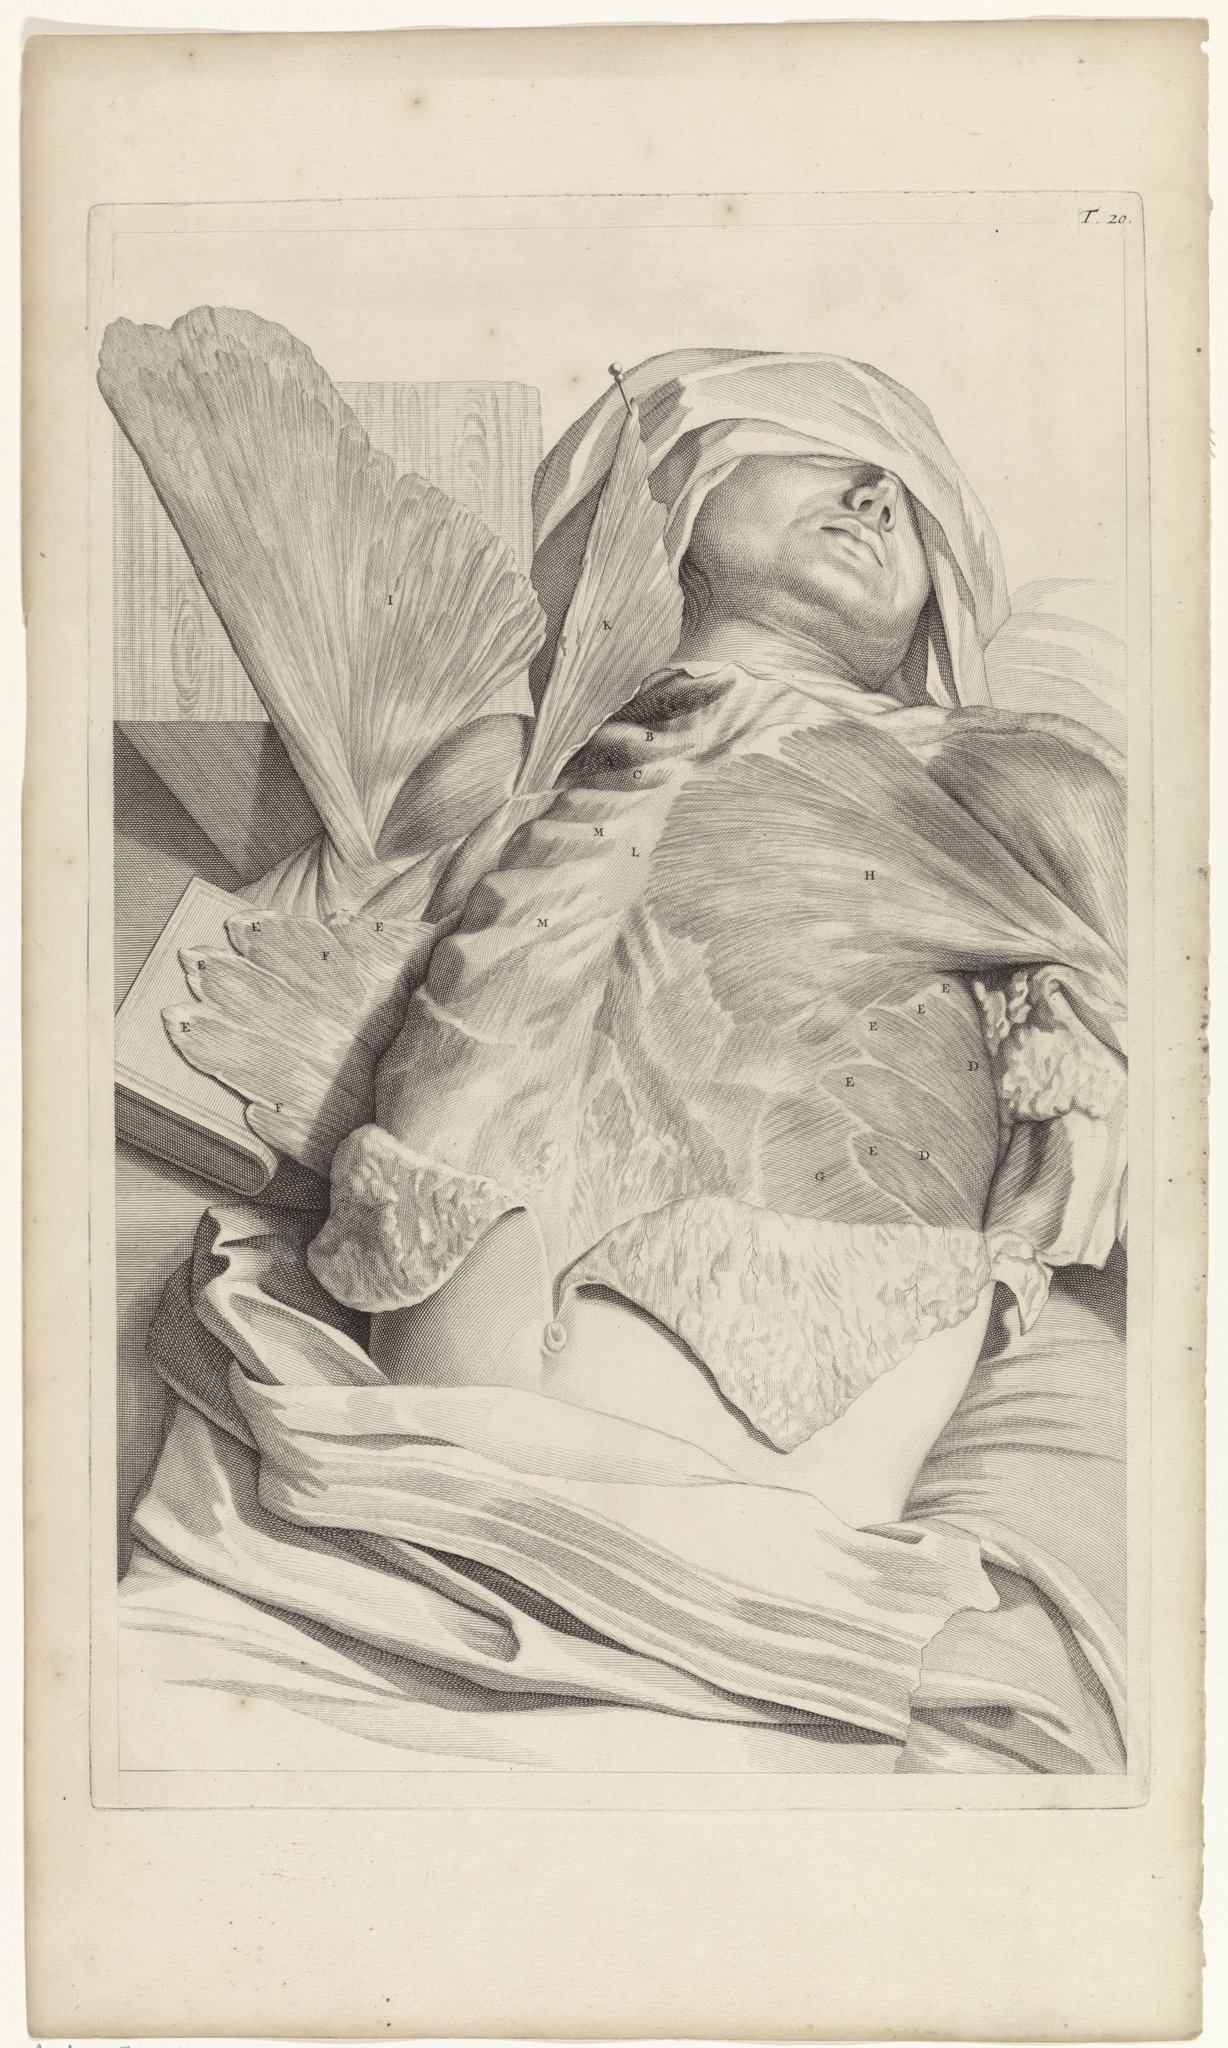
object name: print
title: Anatomische studie van de spieren van het bovenlichaam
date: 1685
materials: paper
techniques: engraving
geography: amsterdam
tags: chest, bust, muscles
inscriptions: collector's mark: Lugt 2228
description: Boekillustratie voor Bidloo, Godefridus. Anatomia humani corporis centum & quinque tabulis, per art. G. de Lairesse ad vivum delineatis, de monstrata, veterum recentiorumque inventis explicata plurimisque, hactenus non detectis, illustrata. Amsterdam: Weduwe Joannes van Someren, Hendrick Boom en erven Dirk Boom, 1685.